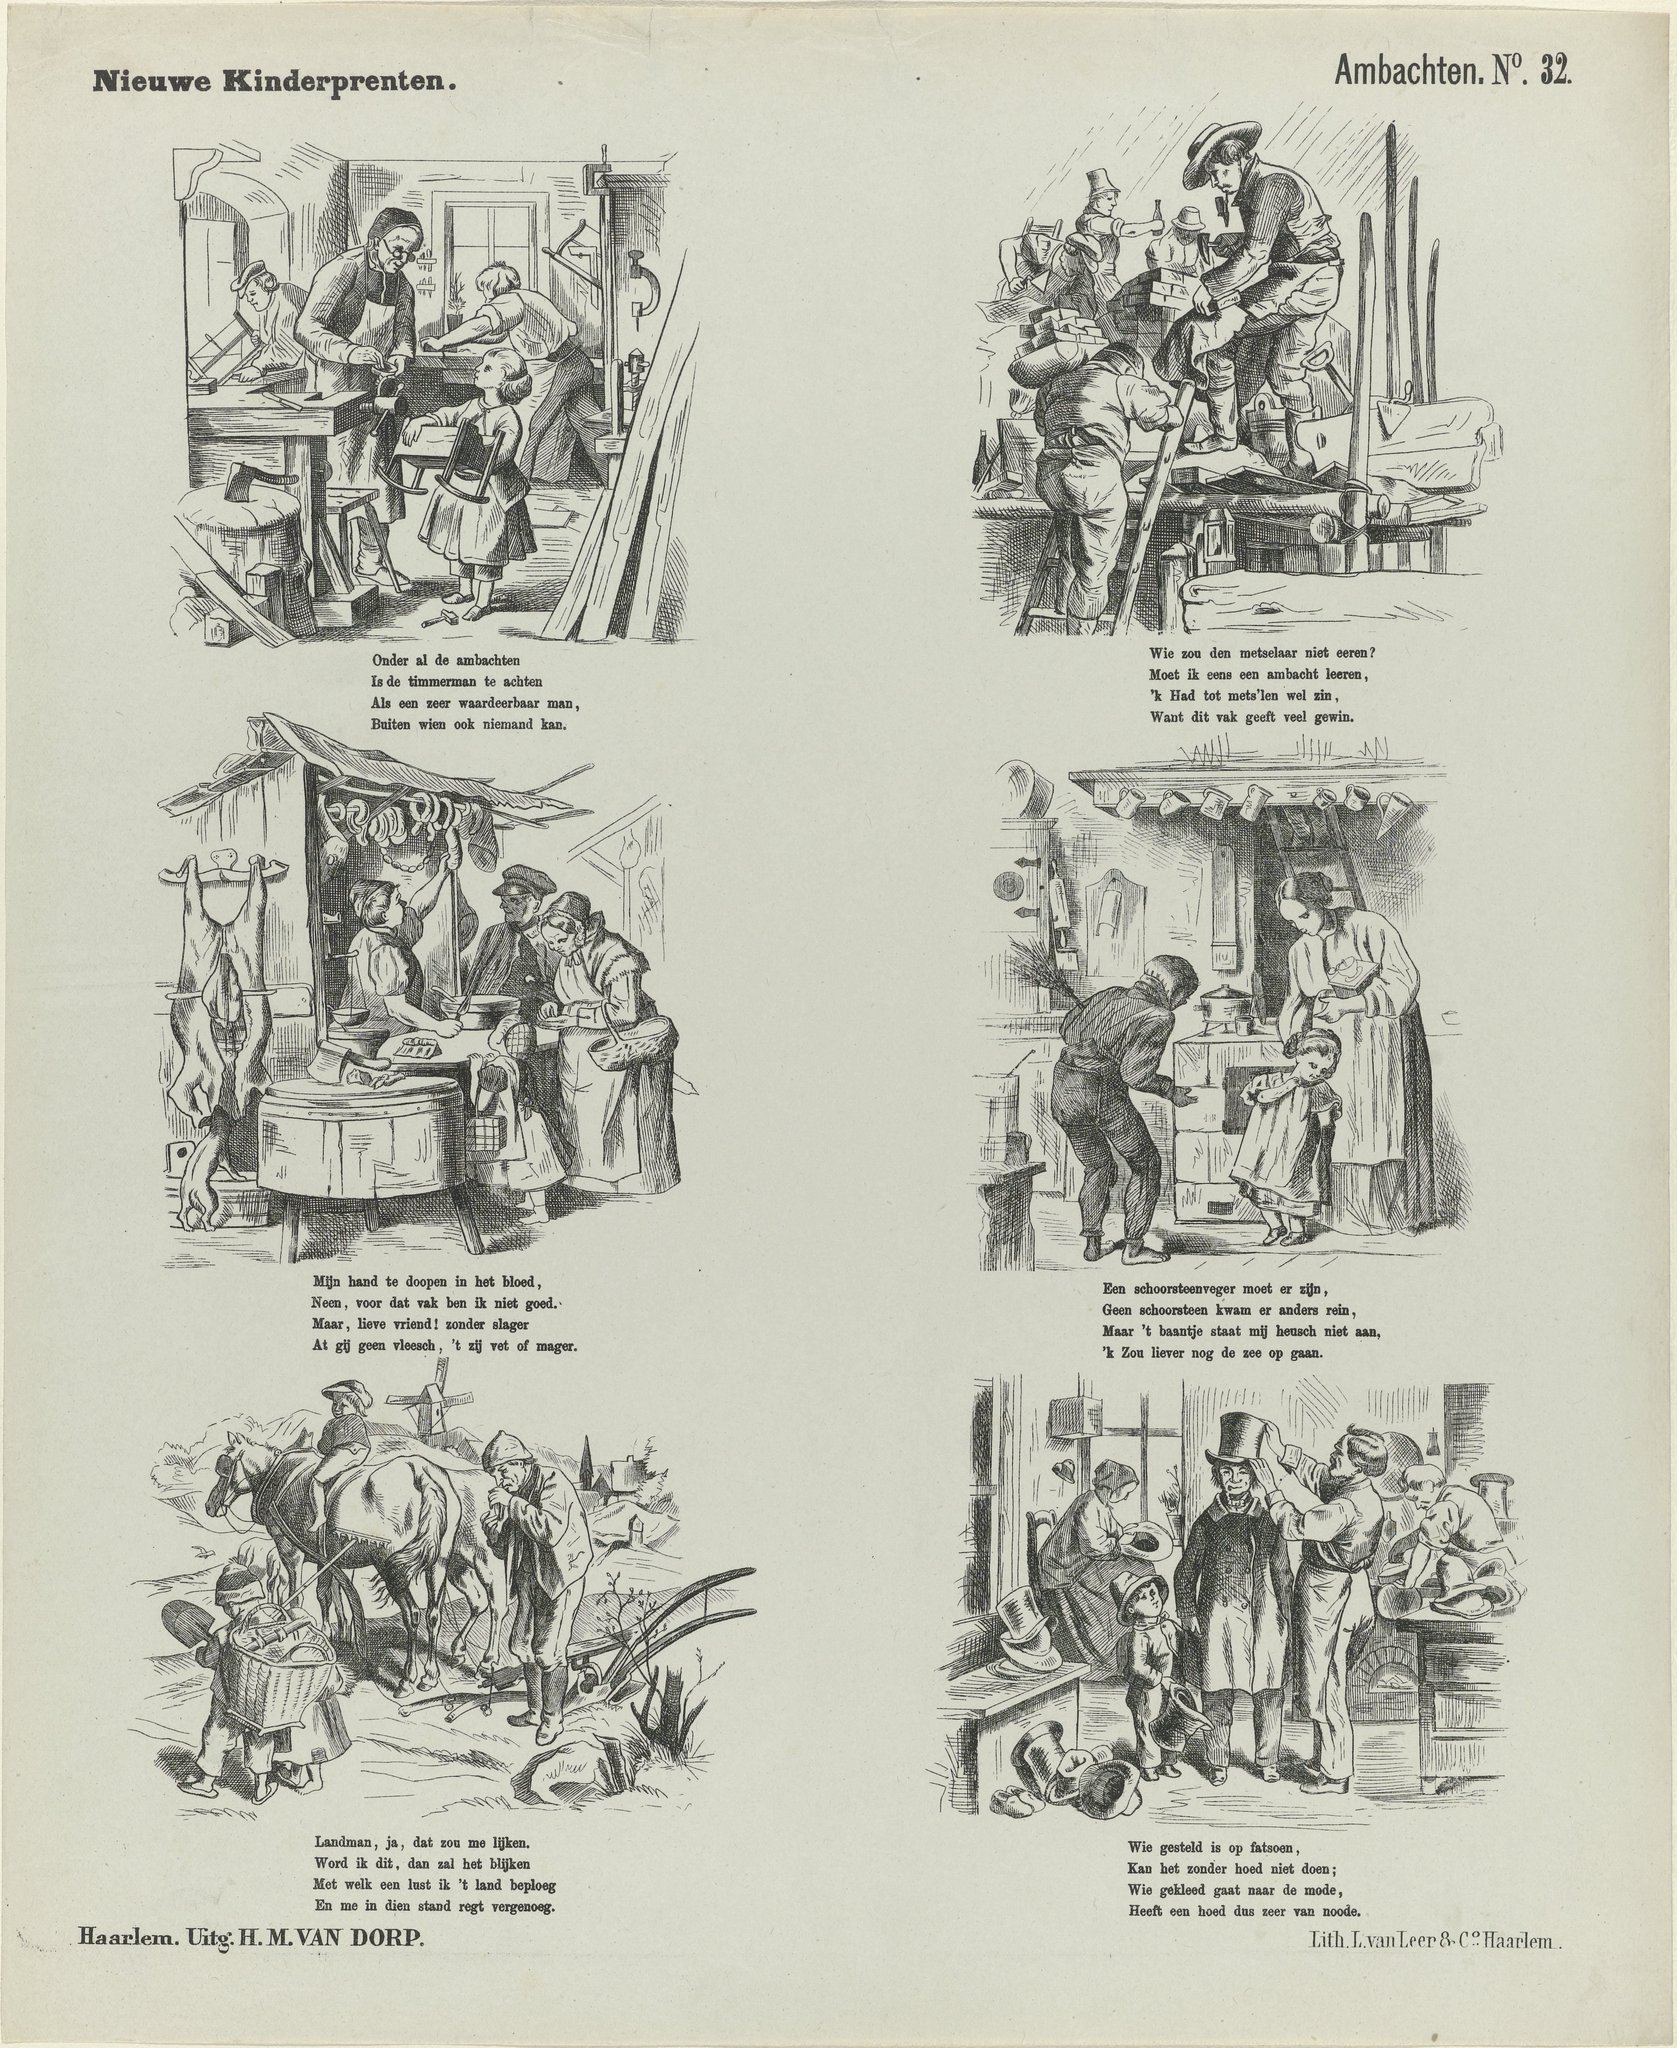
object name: popular print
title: Ambachten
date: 1872-1883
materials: paper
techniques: letterpress printing, lithograph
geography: haarlem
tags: carpenter, craft-production, skilled handiwork, handicrafts ~ maintenance and repair (with name of trade or profession), mason at work, crafts and industries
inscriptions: collector's mark: Lugt 2760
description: Blad met 6 voorstellingen van ambachtslieden en beroepen, zoals timmerman, schoorsteenveger en hoedenmaker. Onder elke afbeelding een vierregelig vers. Genummerd rechtsboven: No. 32.